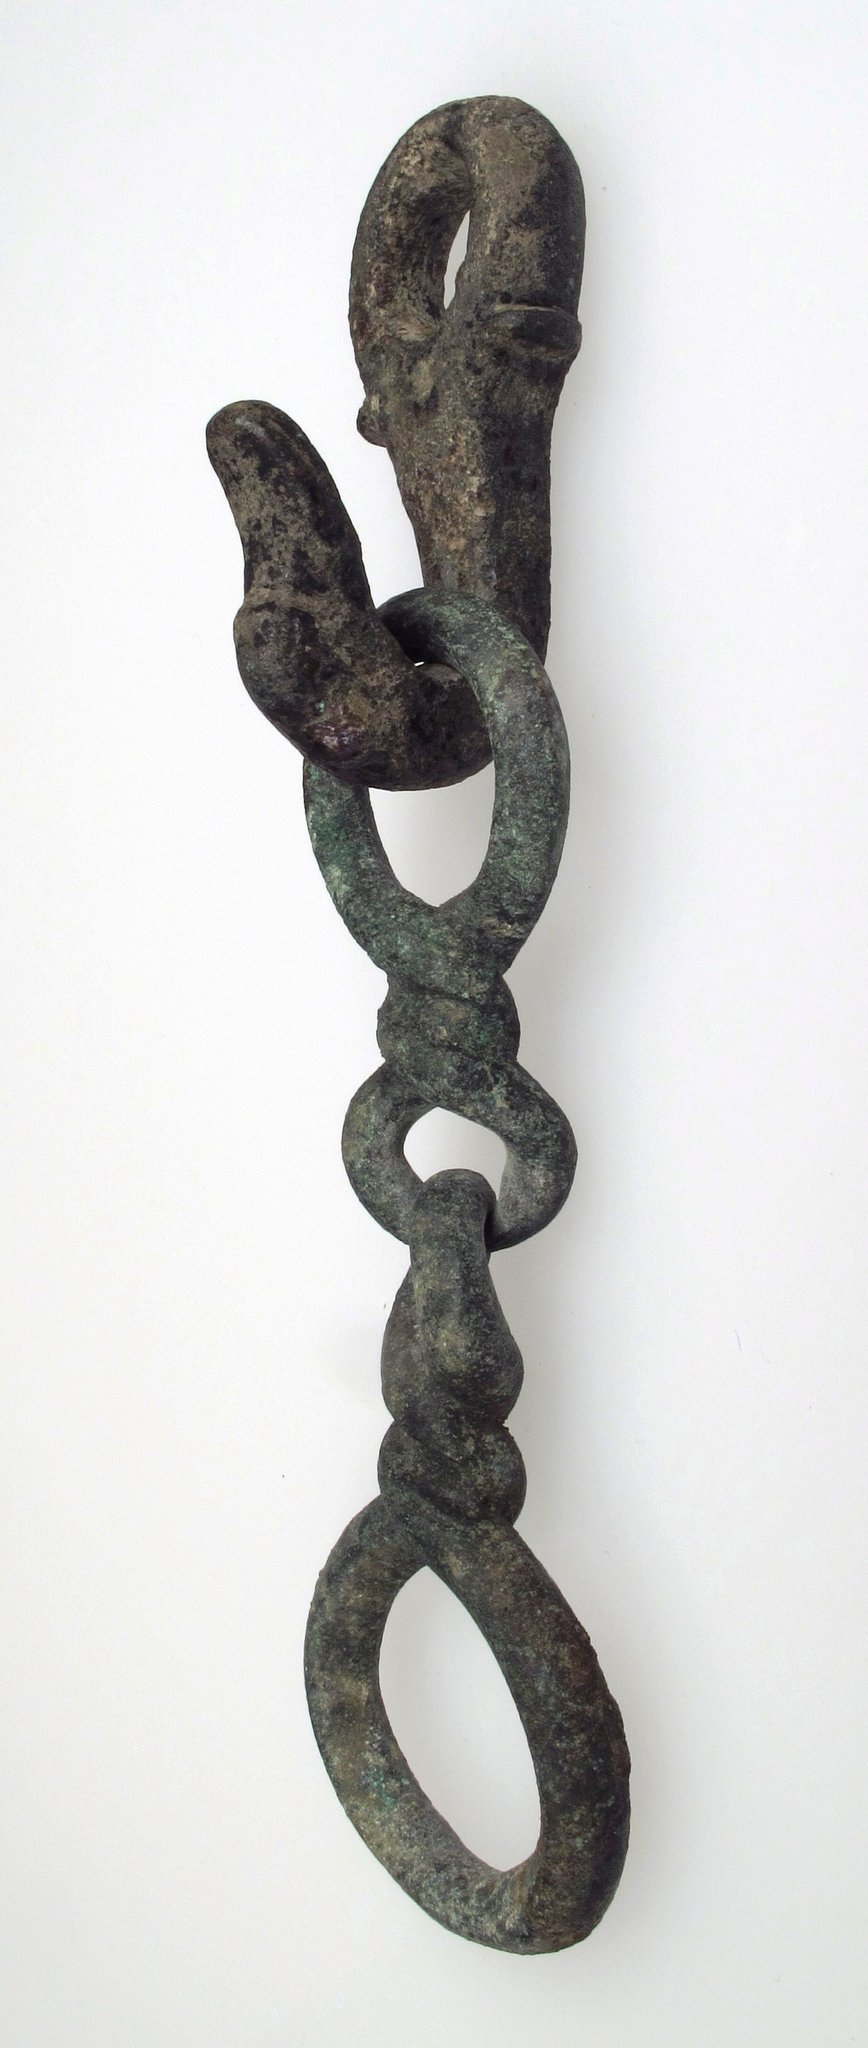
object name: trapping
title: Horse Trapping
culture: celtic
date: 400-100 BCE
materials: copper alloy